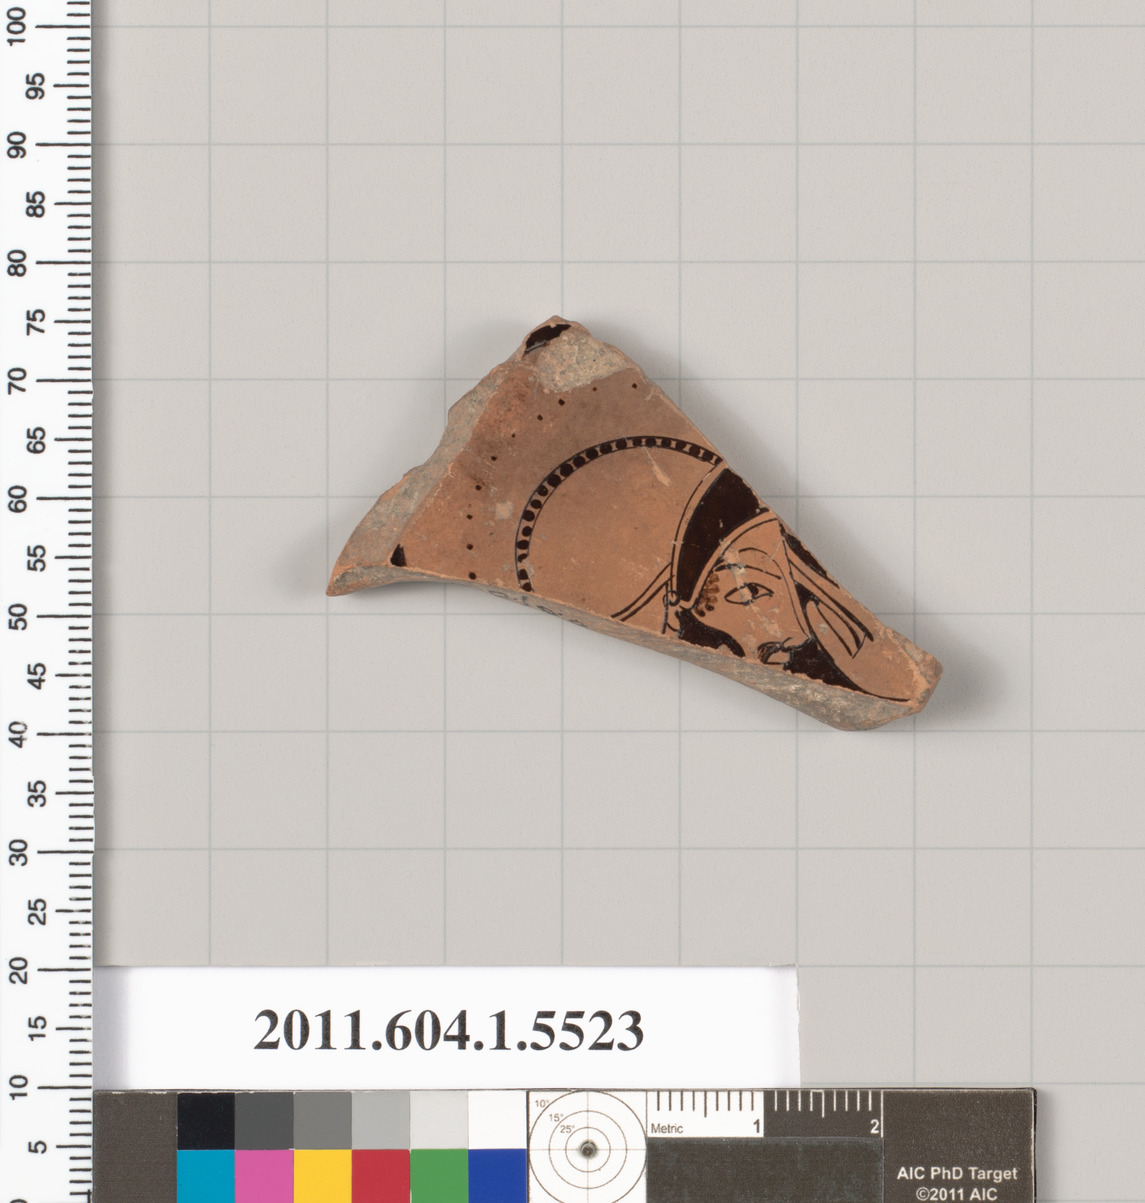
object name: kylix fragment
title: Terracotta fragment of a kylix (drinking cup)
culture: greek, attic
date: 510-490 BCE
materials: terracotta